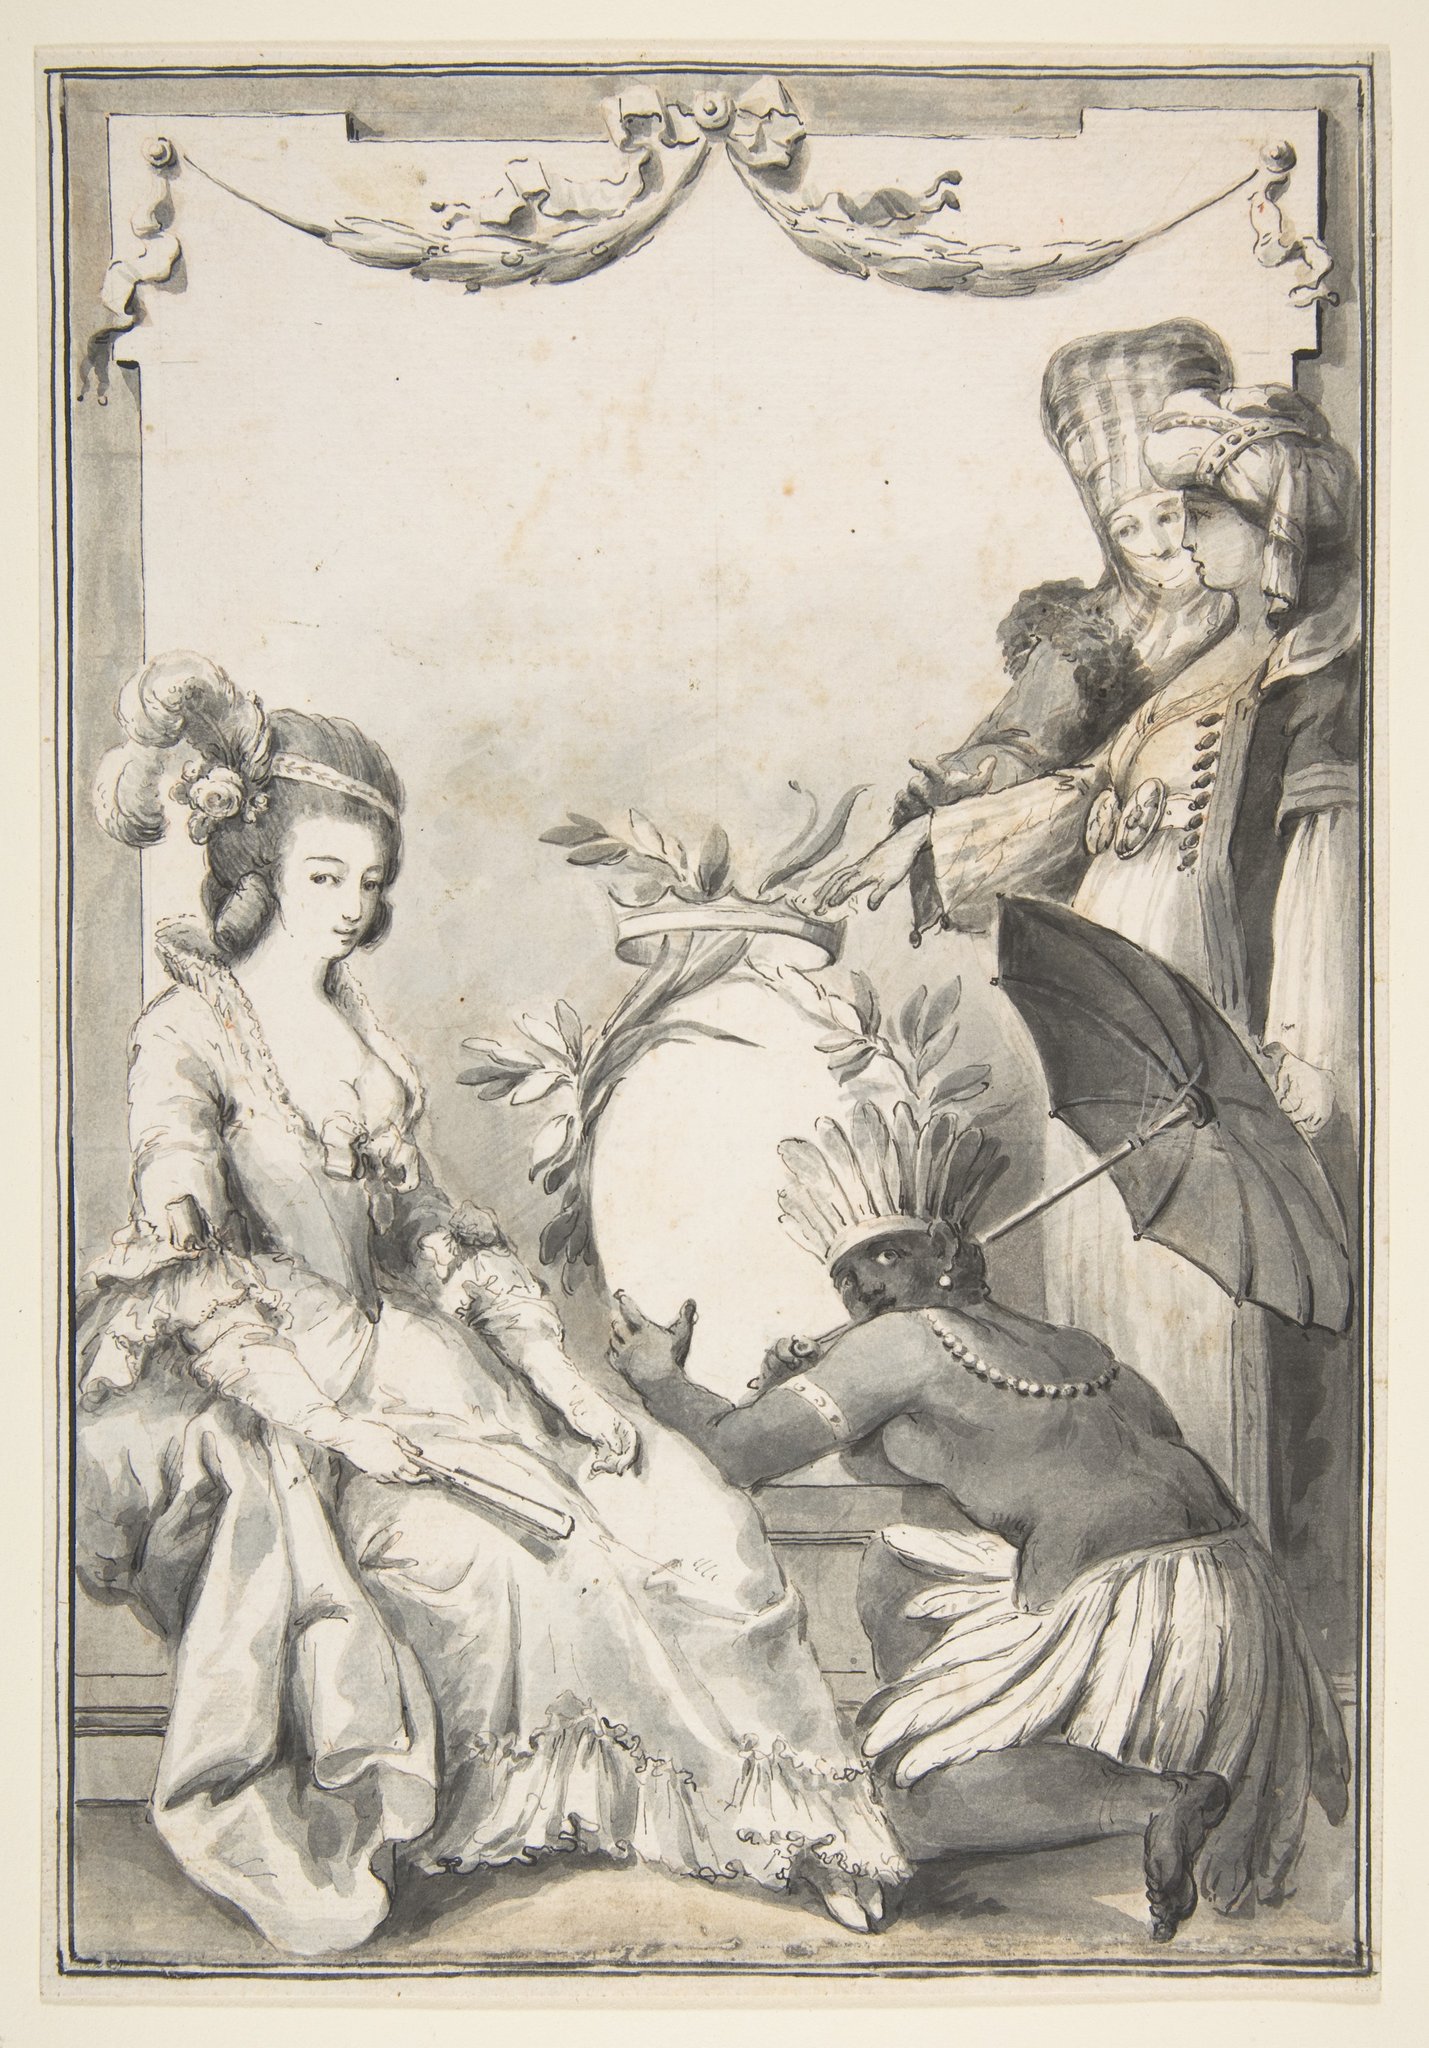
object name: drawing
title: Allegorical Figures of the Four Continents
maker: teodoro viero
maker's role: artist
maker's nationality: italian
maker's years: 1740-1819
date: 1783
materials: ink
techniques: brush, pen, wash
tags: men,women